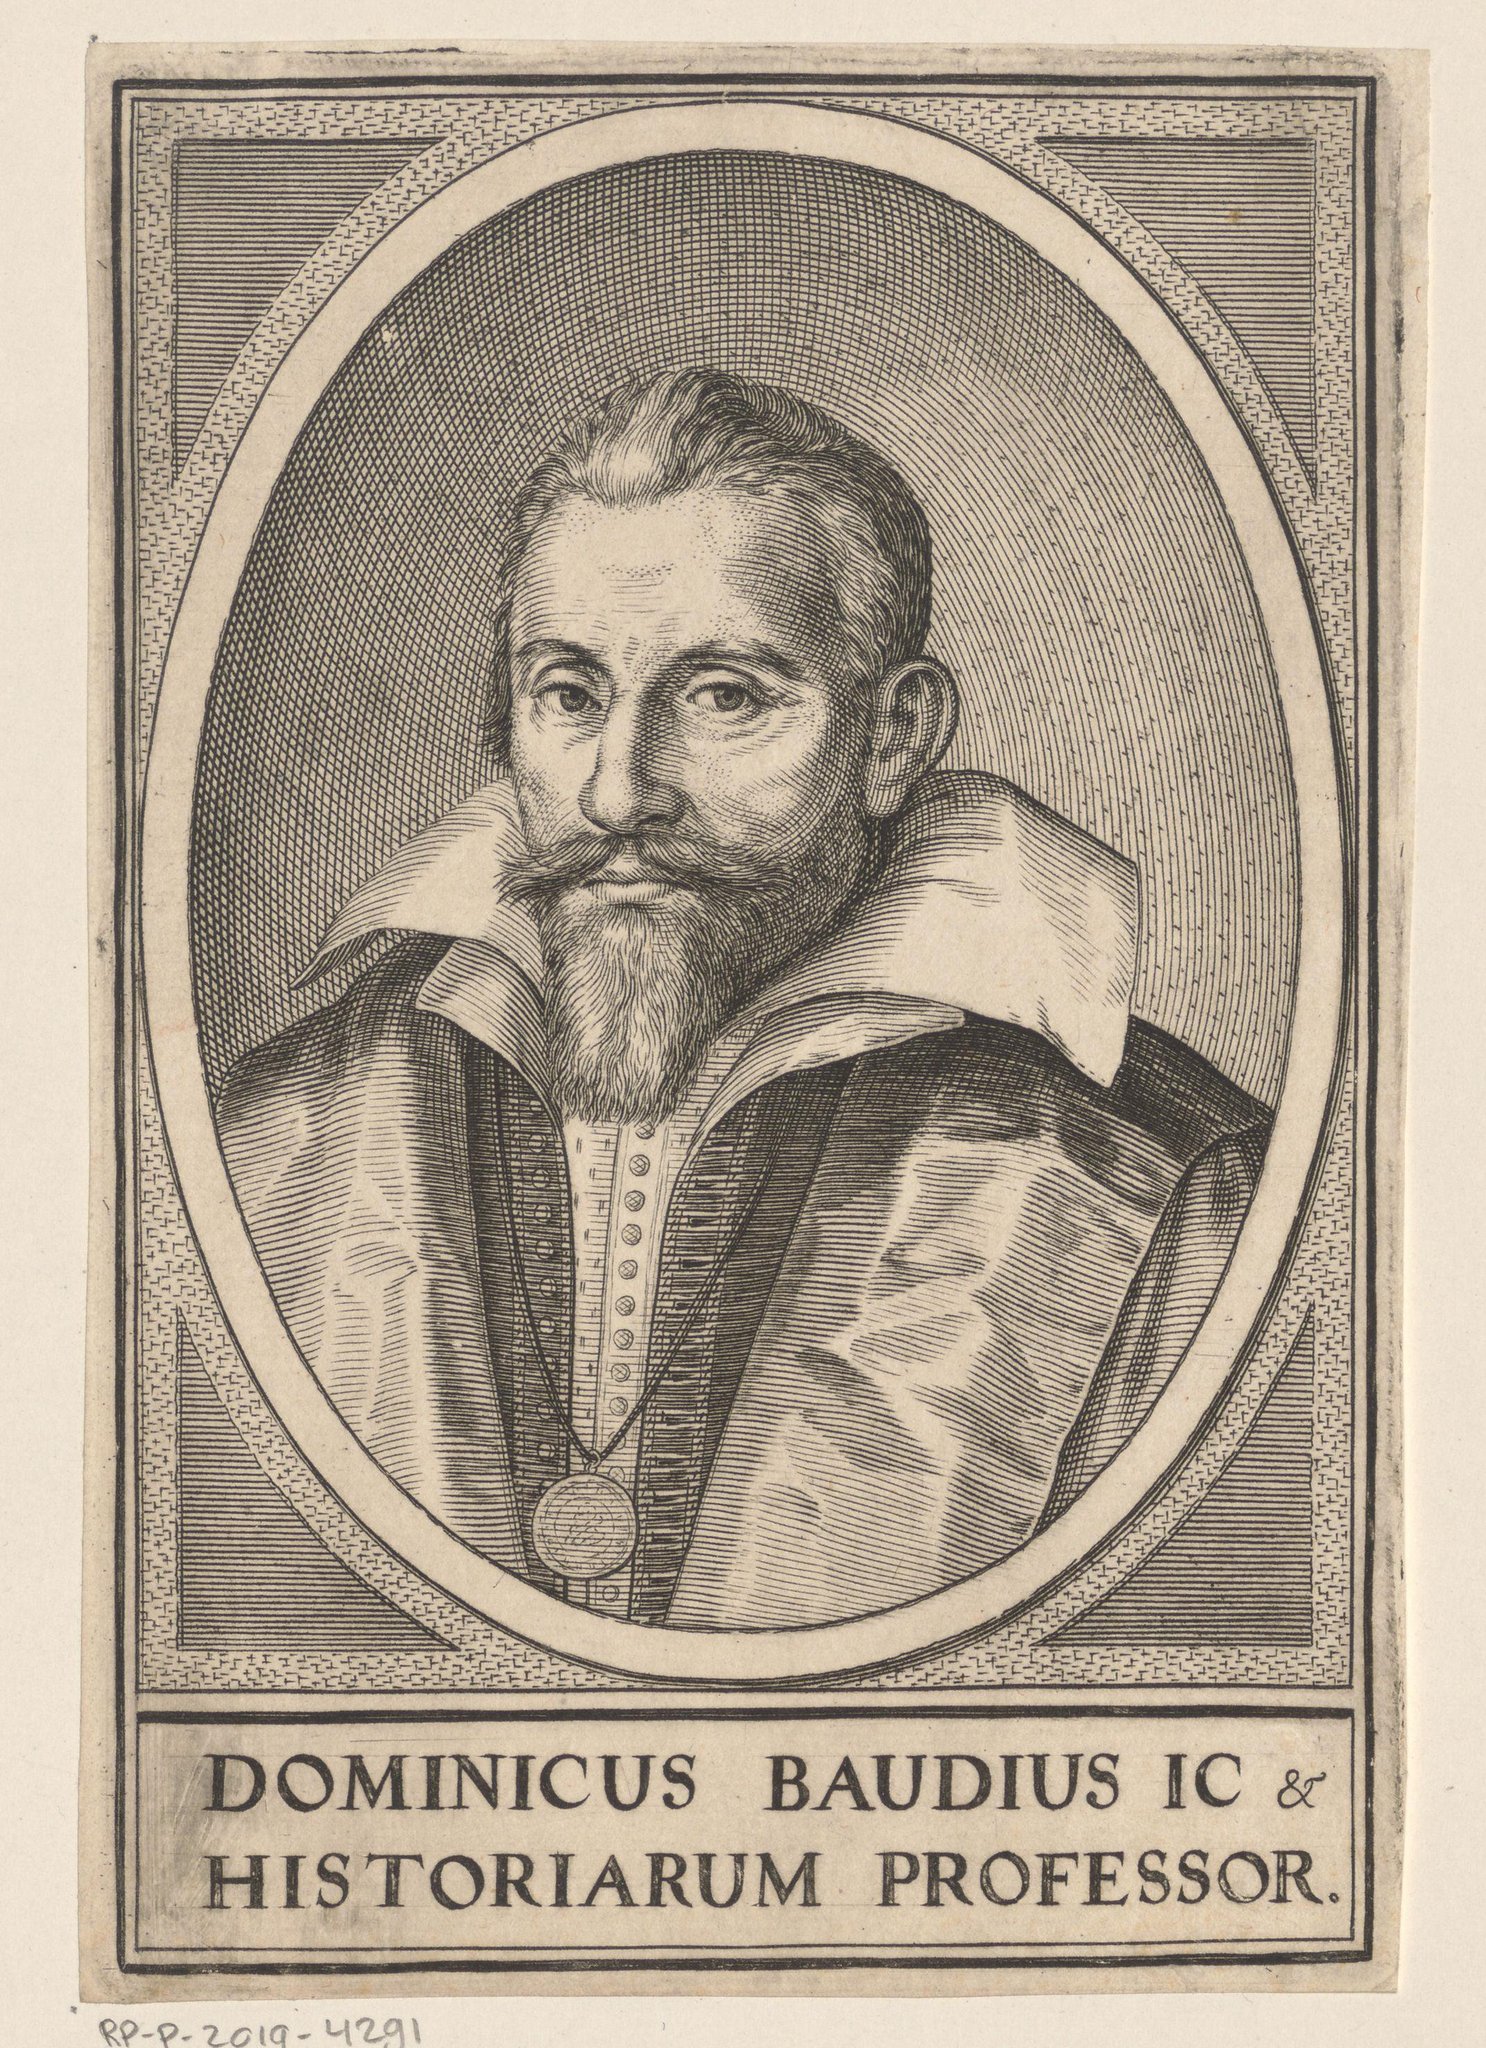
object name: print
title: Icones ad vivum delineatae et expressae virorum clariorum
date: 1609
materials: paper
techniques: engraving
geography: leiden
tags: lille, leiden, dominicus baudius, historical persons, writer, poet, author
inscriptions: inscription: ‘P. Mariette 1644’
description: Prent met tekst op verso verschenen in de 1613- en de 1617-editie van deze prentserie. Prent ook gebruikt in: Meursius, Joannes. Athenae Batavae sive de urbe Leidensi, & Academia, (...). Leiden: Andries Clouck en de gebroeders Elzevier, 1625, ook met tekst op verso.